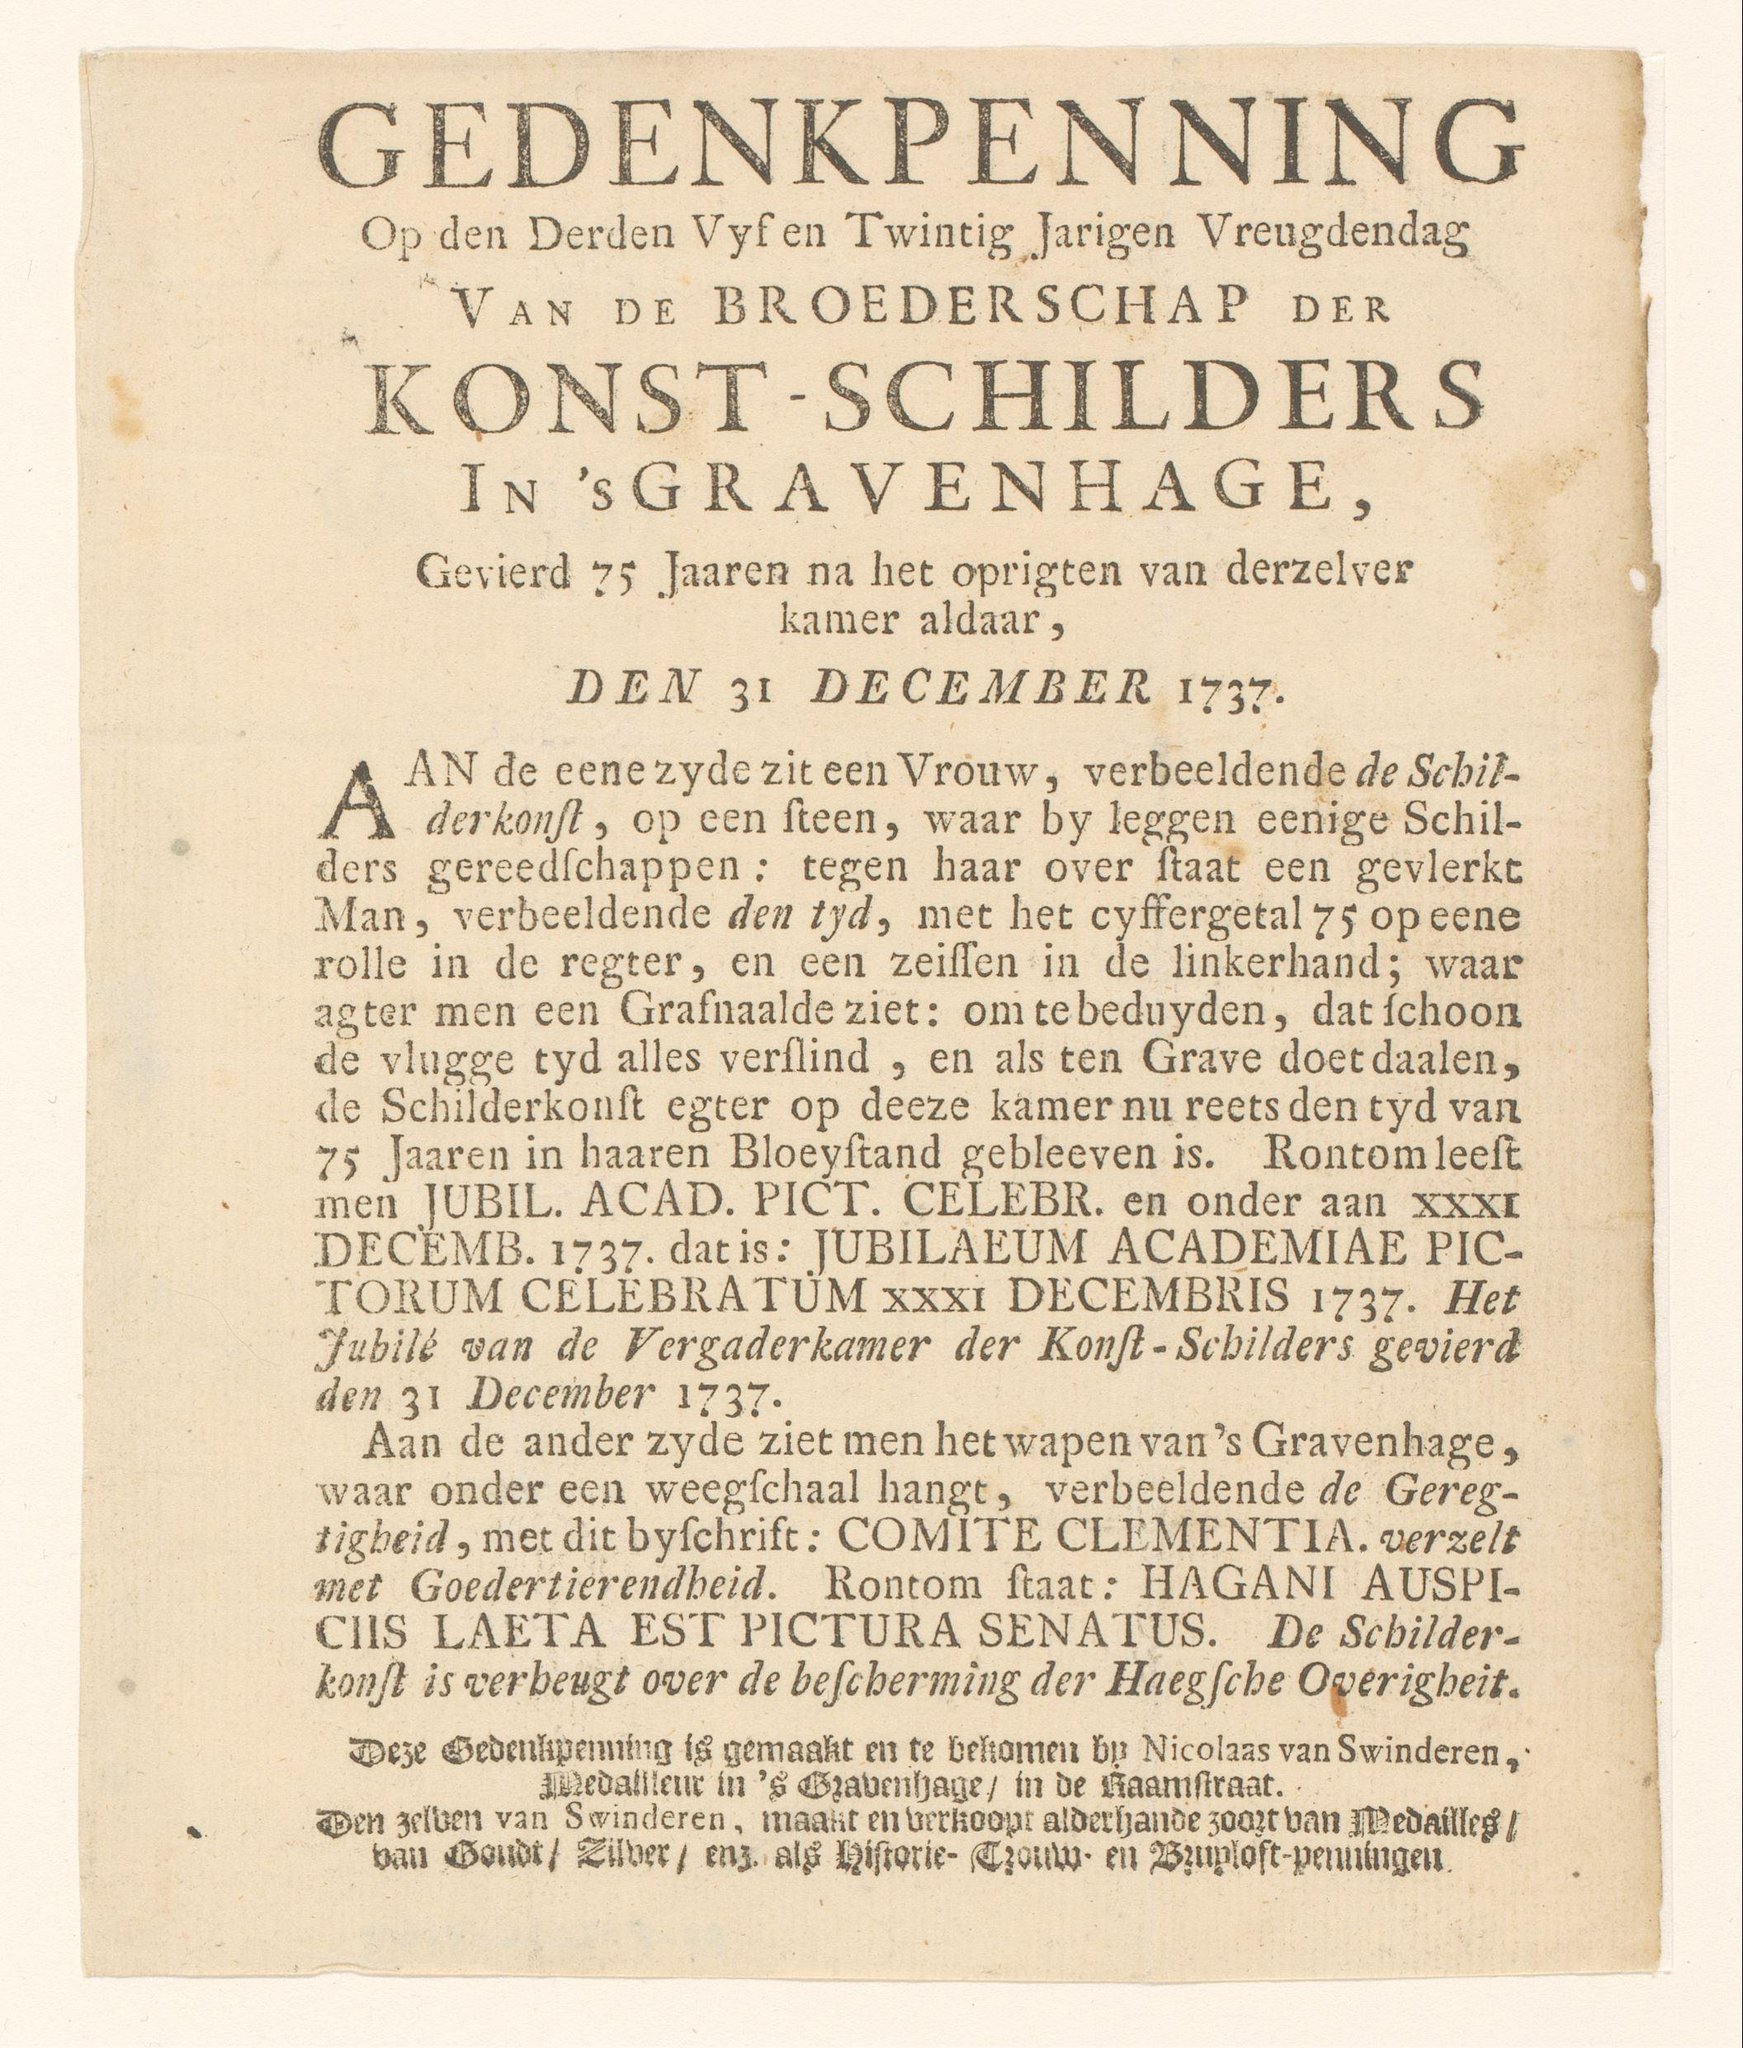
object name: text sheet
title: Gedenkpenning op den derden Vyf en Twintig Jarigen Vreugdendag van de Broederschap der Konst-Schilders in 's Gravenhage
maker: Anonymous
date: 1737-1738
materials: paper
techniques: letterpress printing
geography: the hague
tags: memorial medal, honouring the artist, the hague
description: Onder de beschrijving staat dat de penning gemaakt is door en te verkrijgen is bij Nicolaas van Swinderen.